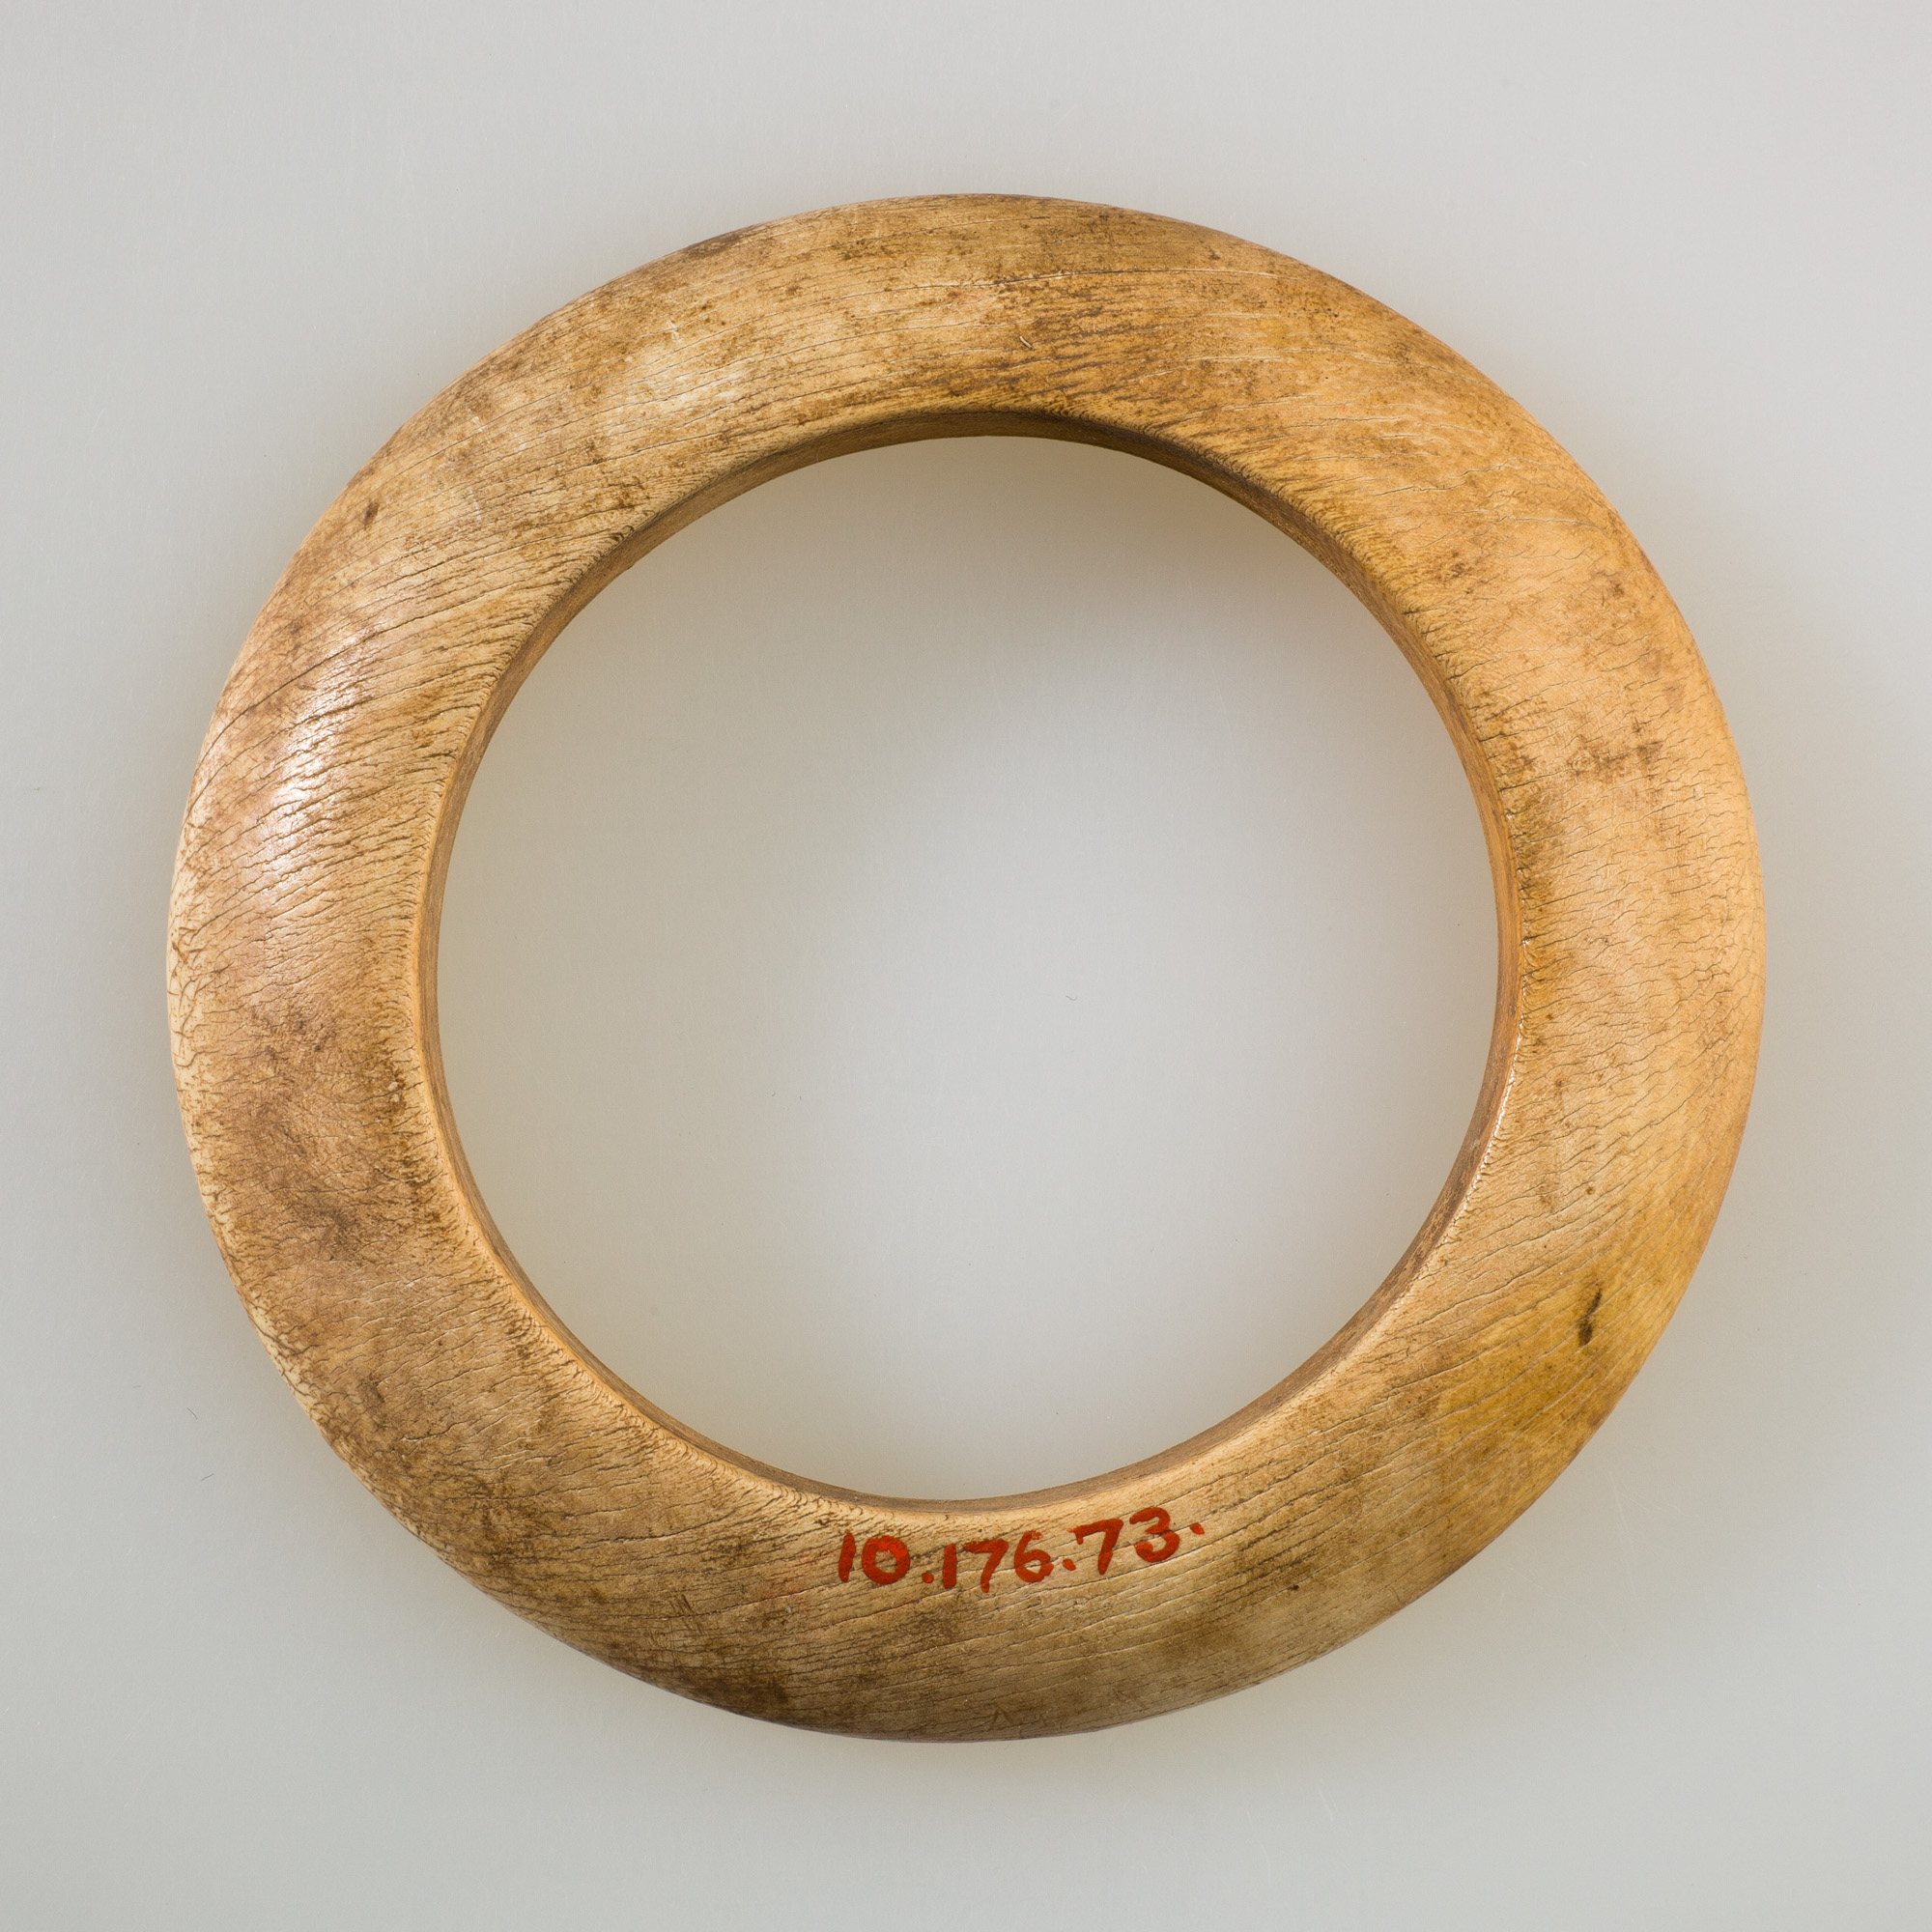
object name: bracelet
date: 3850-2960 BCE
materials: ivory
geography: egypt